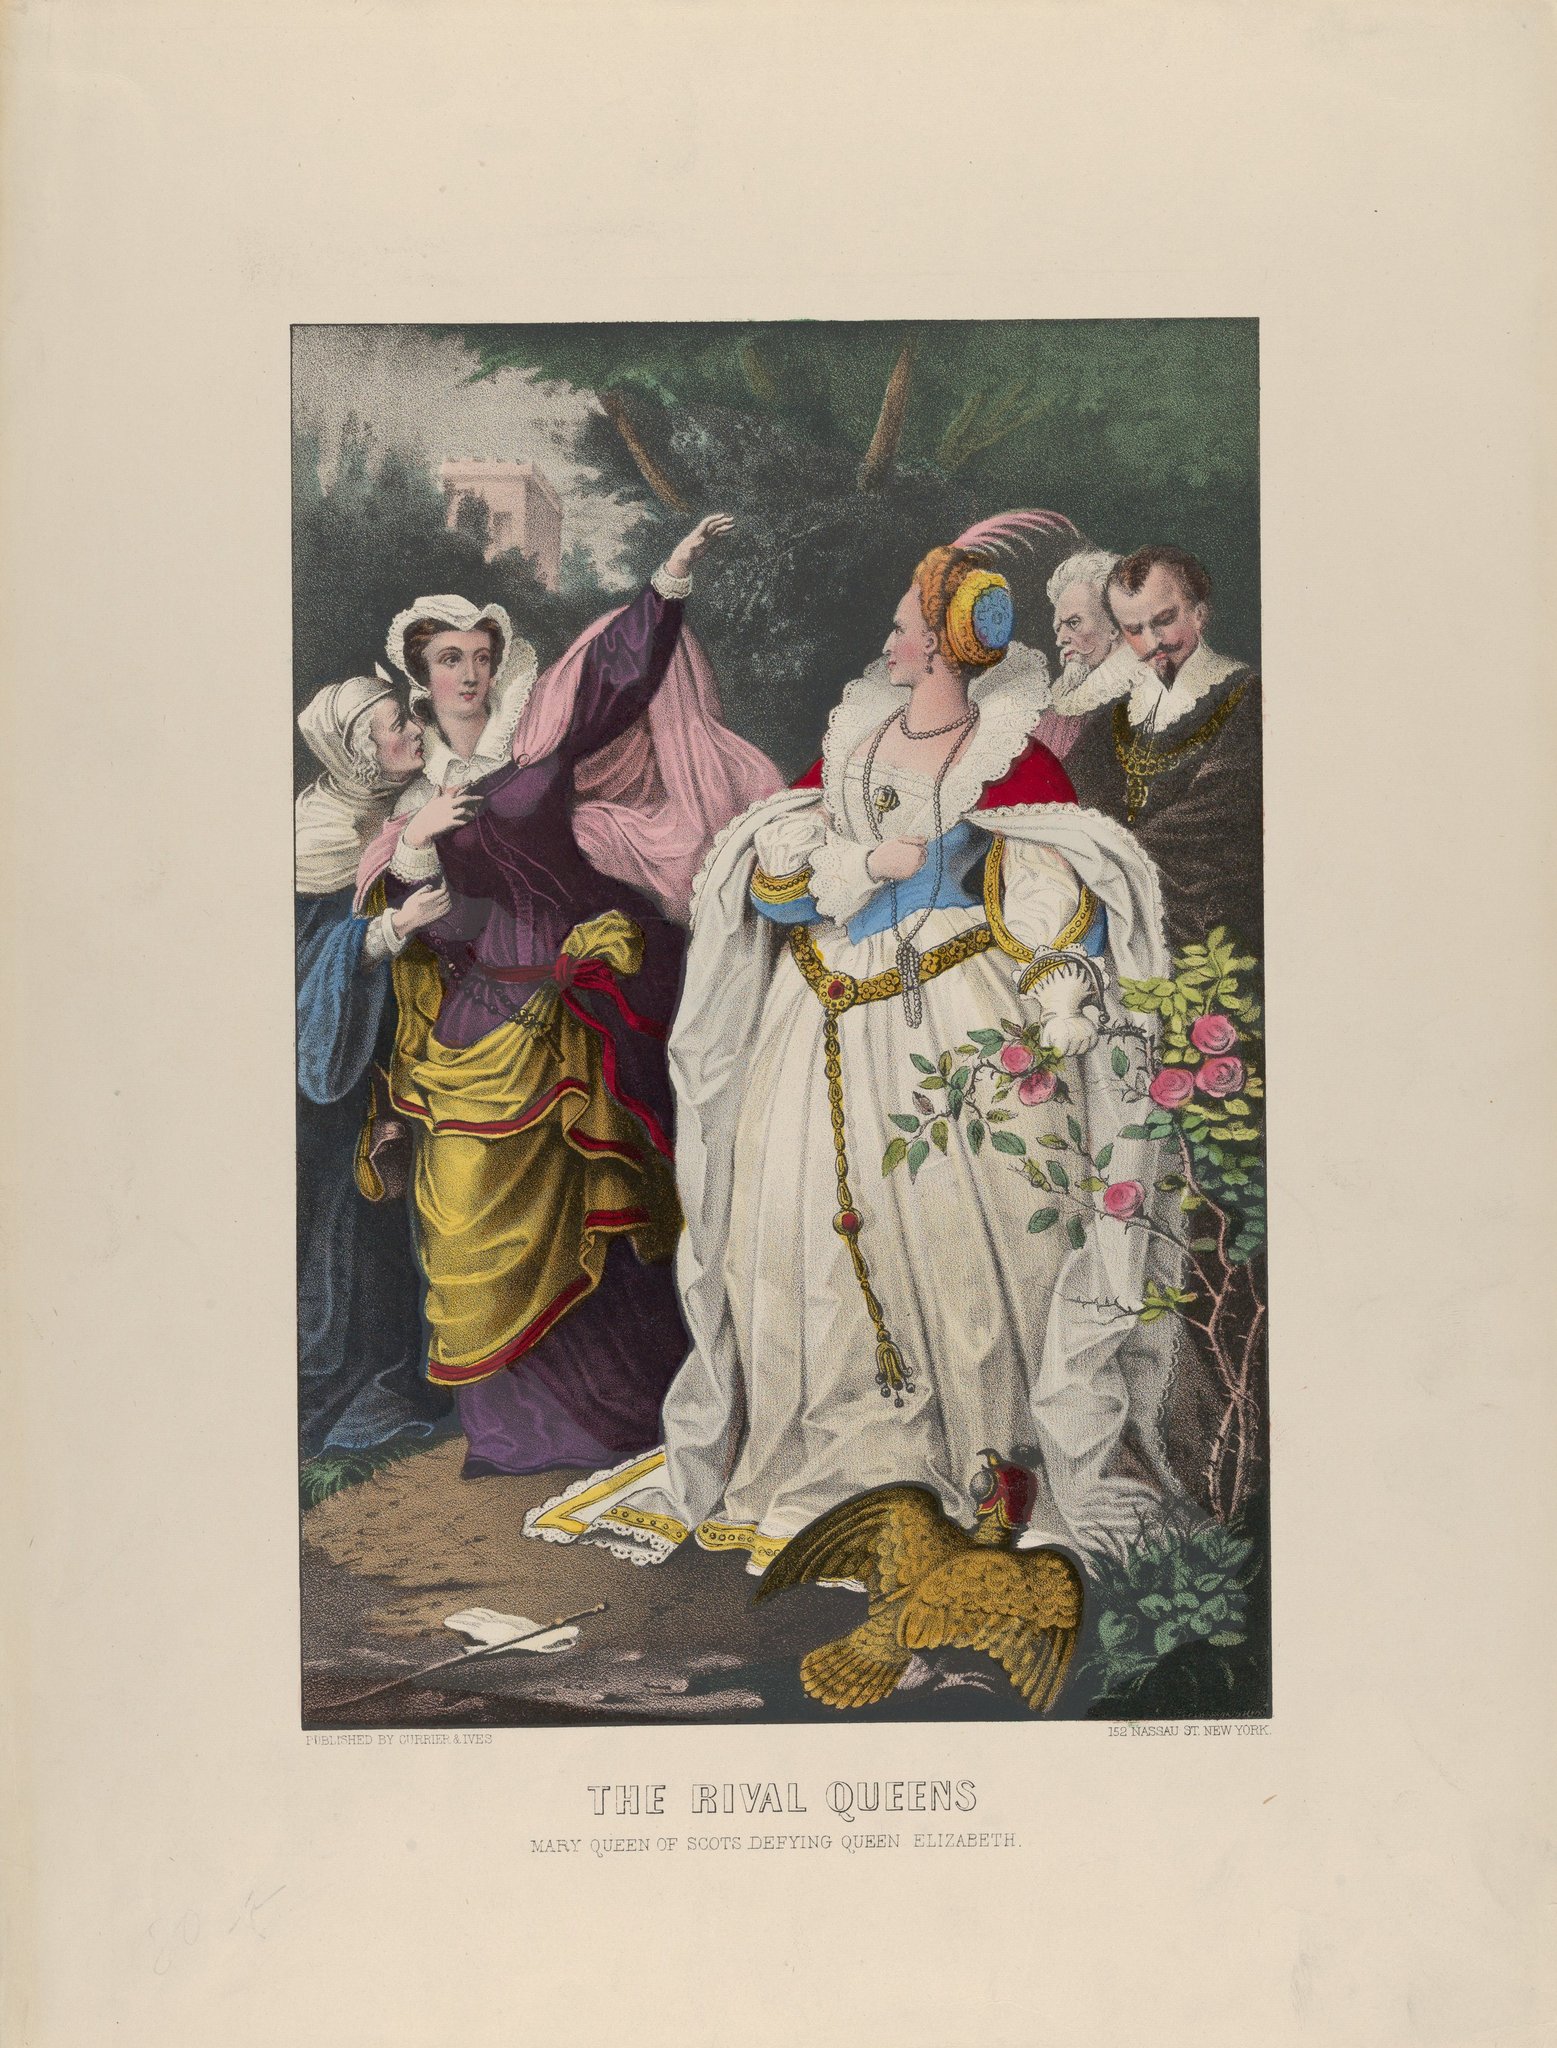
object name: print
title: The Rival Queens – Mary Queen of Scots Defying Queen Elizabeth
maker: currier & ives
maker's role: artist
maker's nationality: american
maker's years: 1857-1907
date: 1857-1871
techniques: hand coloring, lithograph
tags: eagles,elizabeth i,queens,men